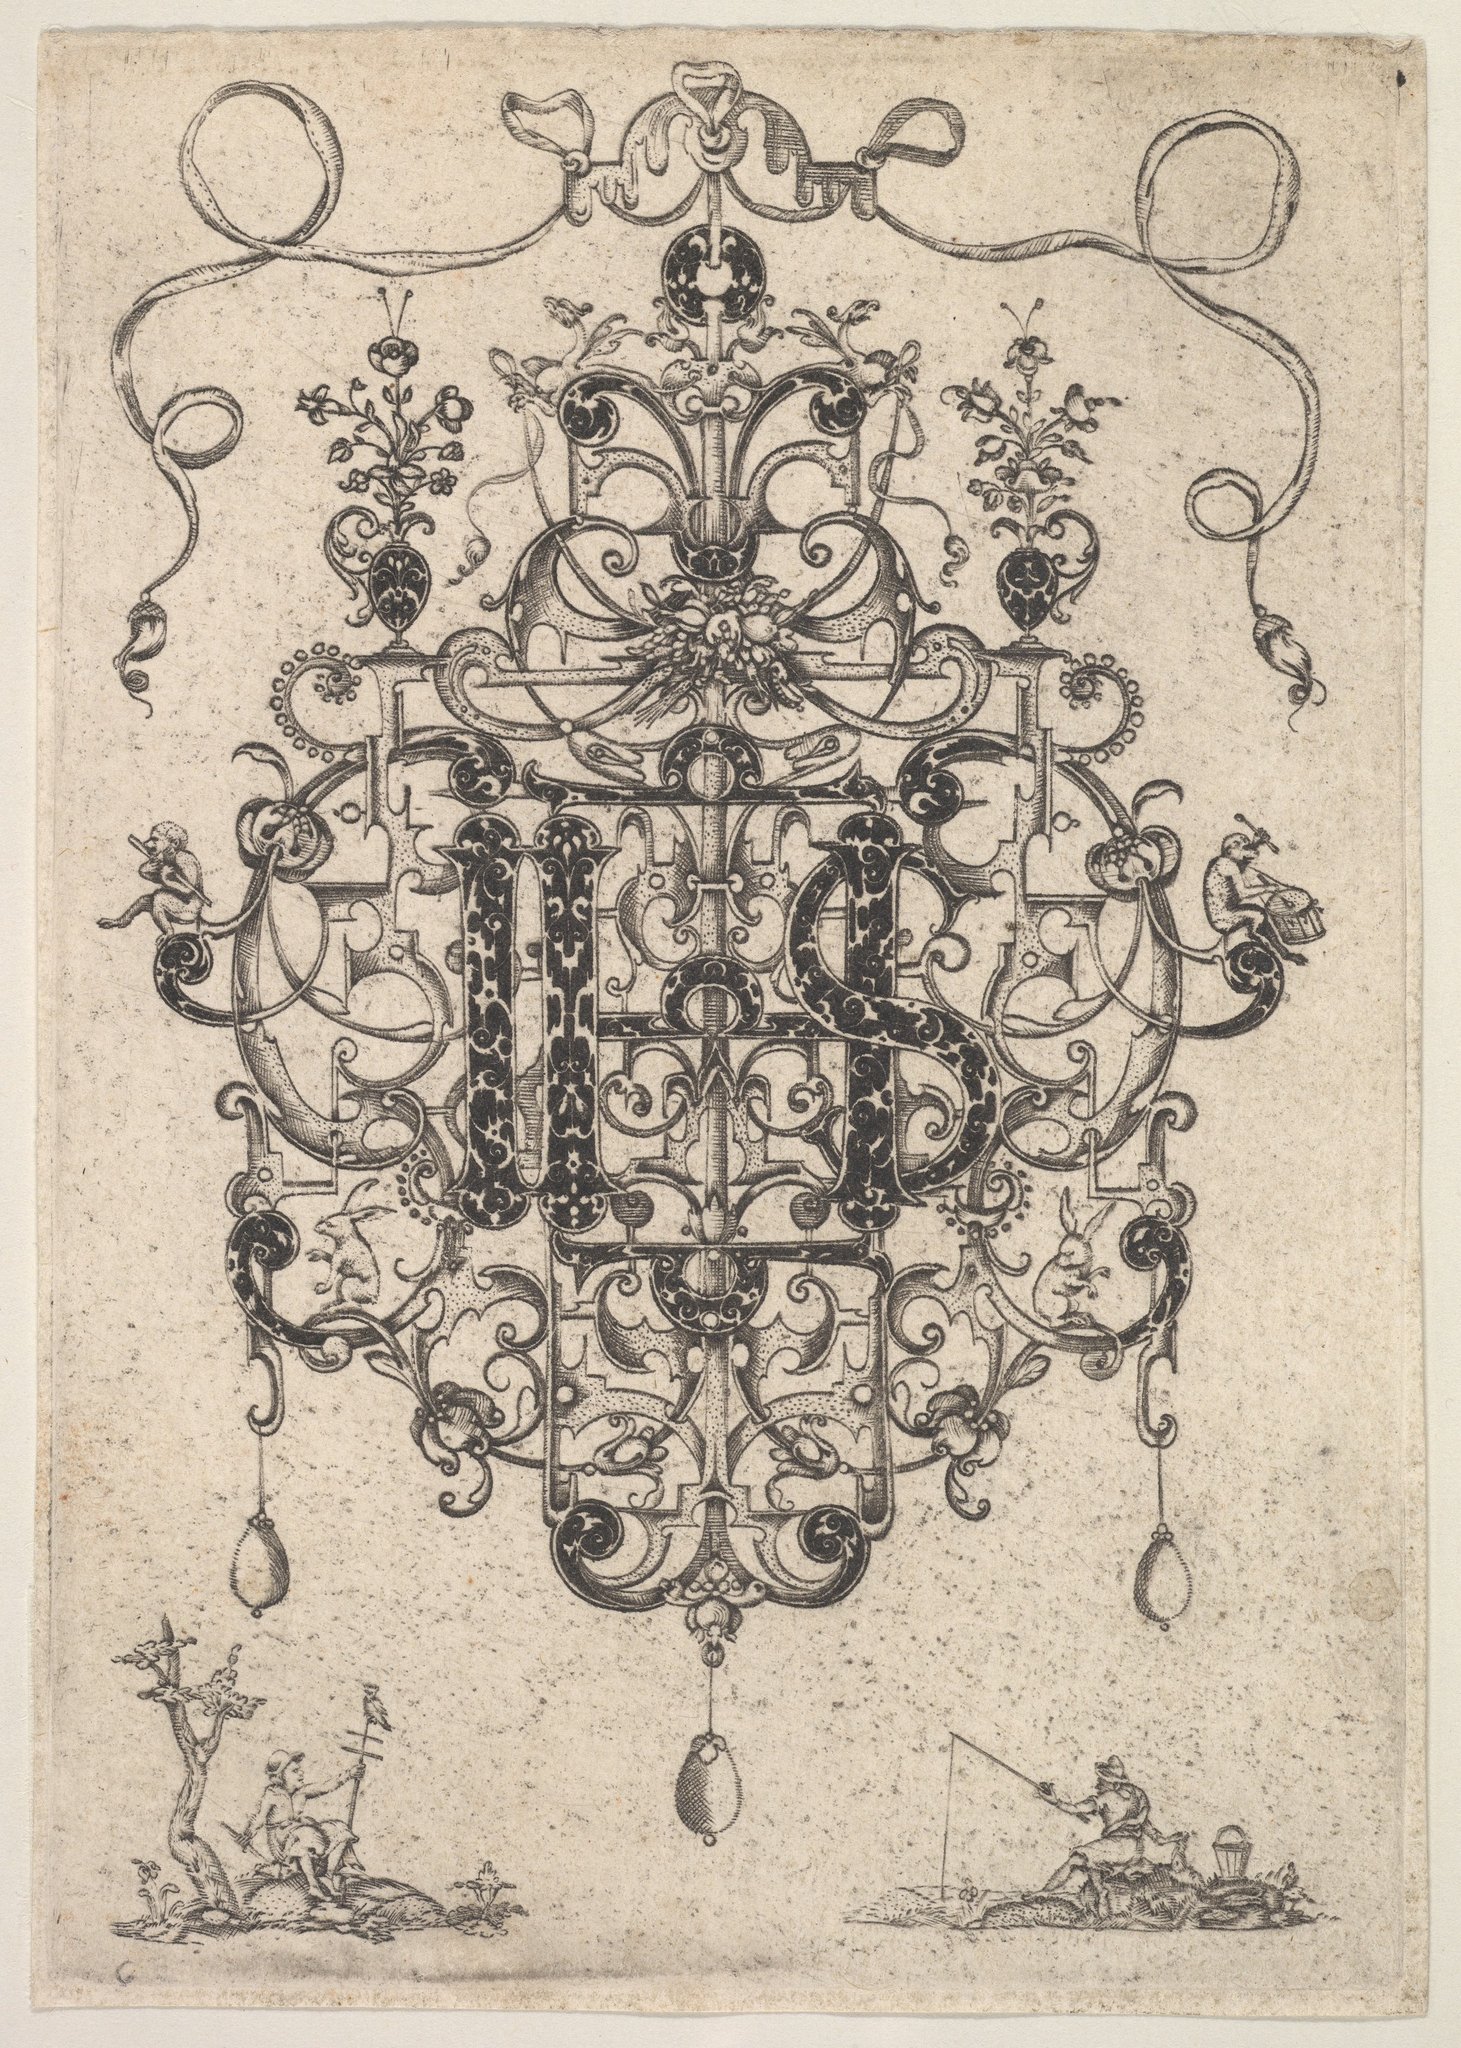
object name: print collection ornament architecture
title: Design for a Pendant with IHS Monogram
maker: master p.r.k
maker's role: artist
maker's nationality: dutch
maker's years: 1609-1617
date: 1609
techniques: embroidery, engraving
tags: pendants